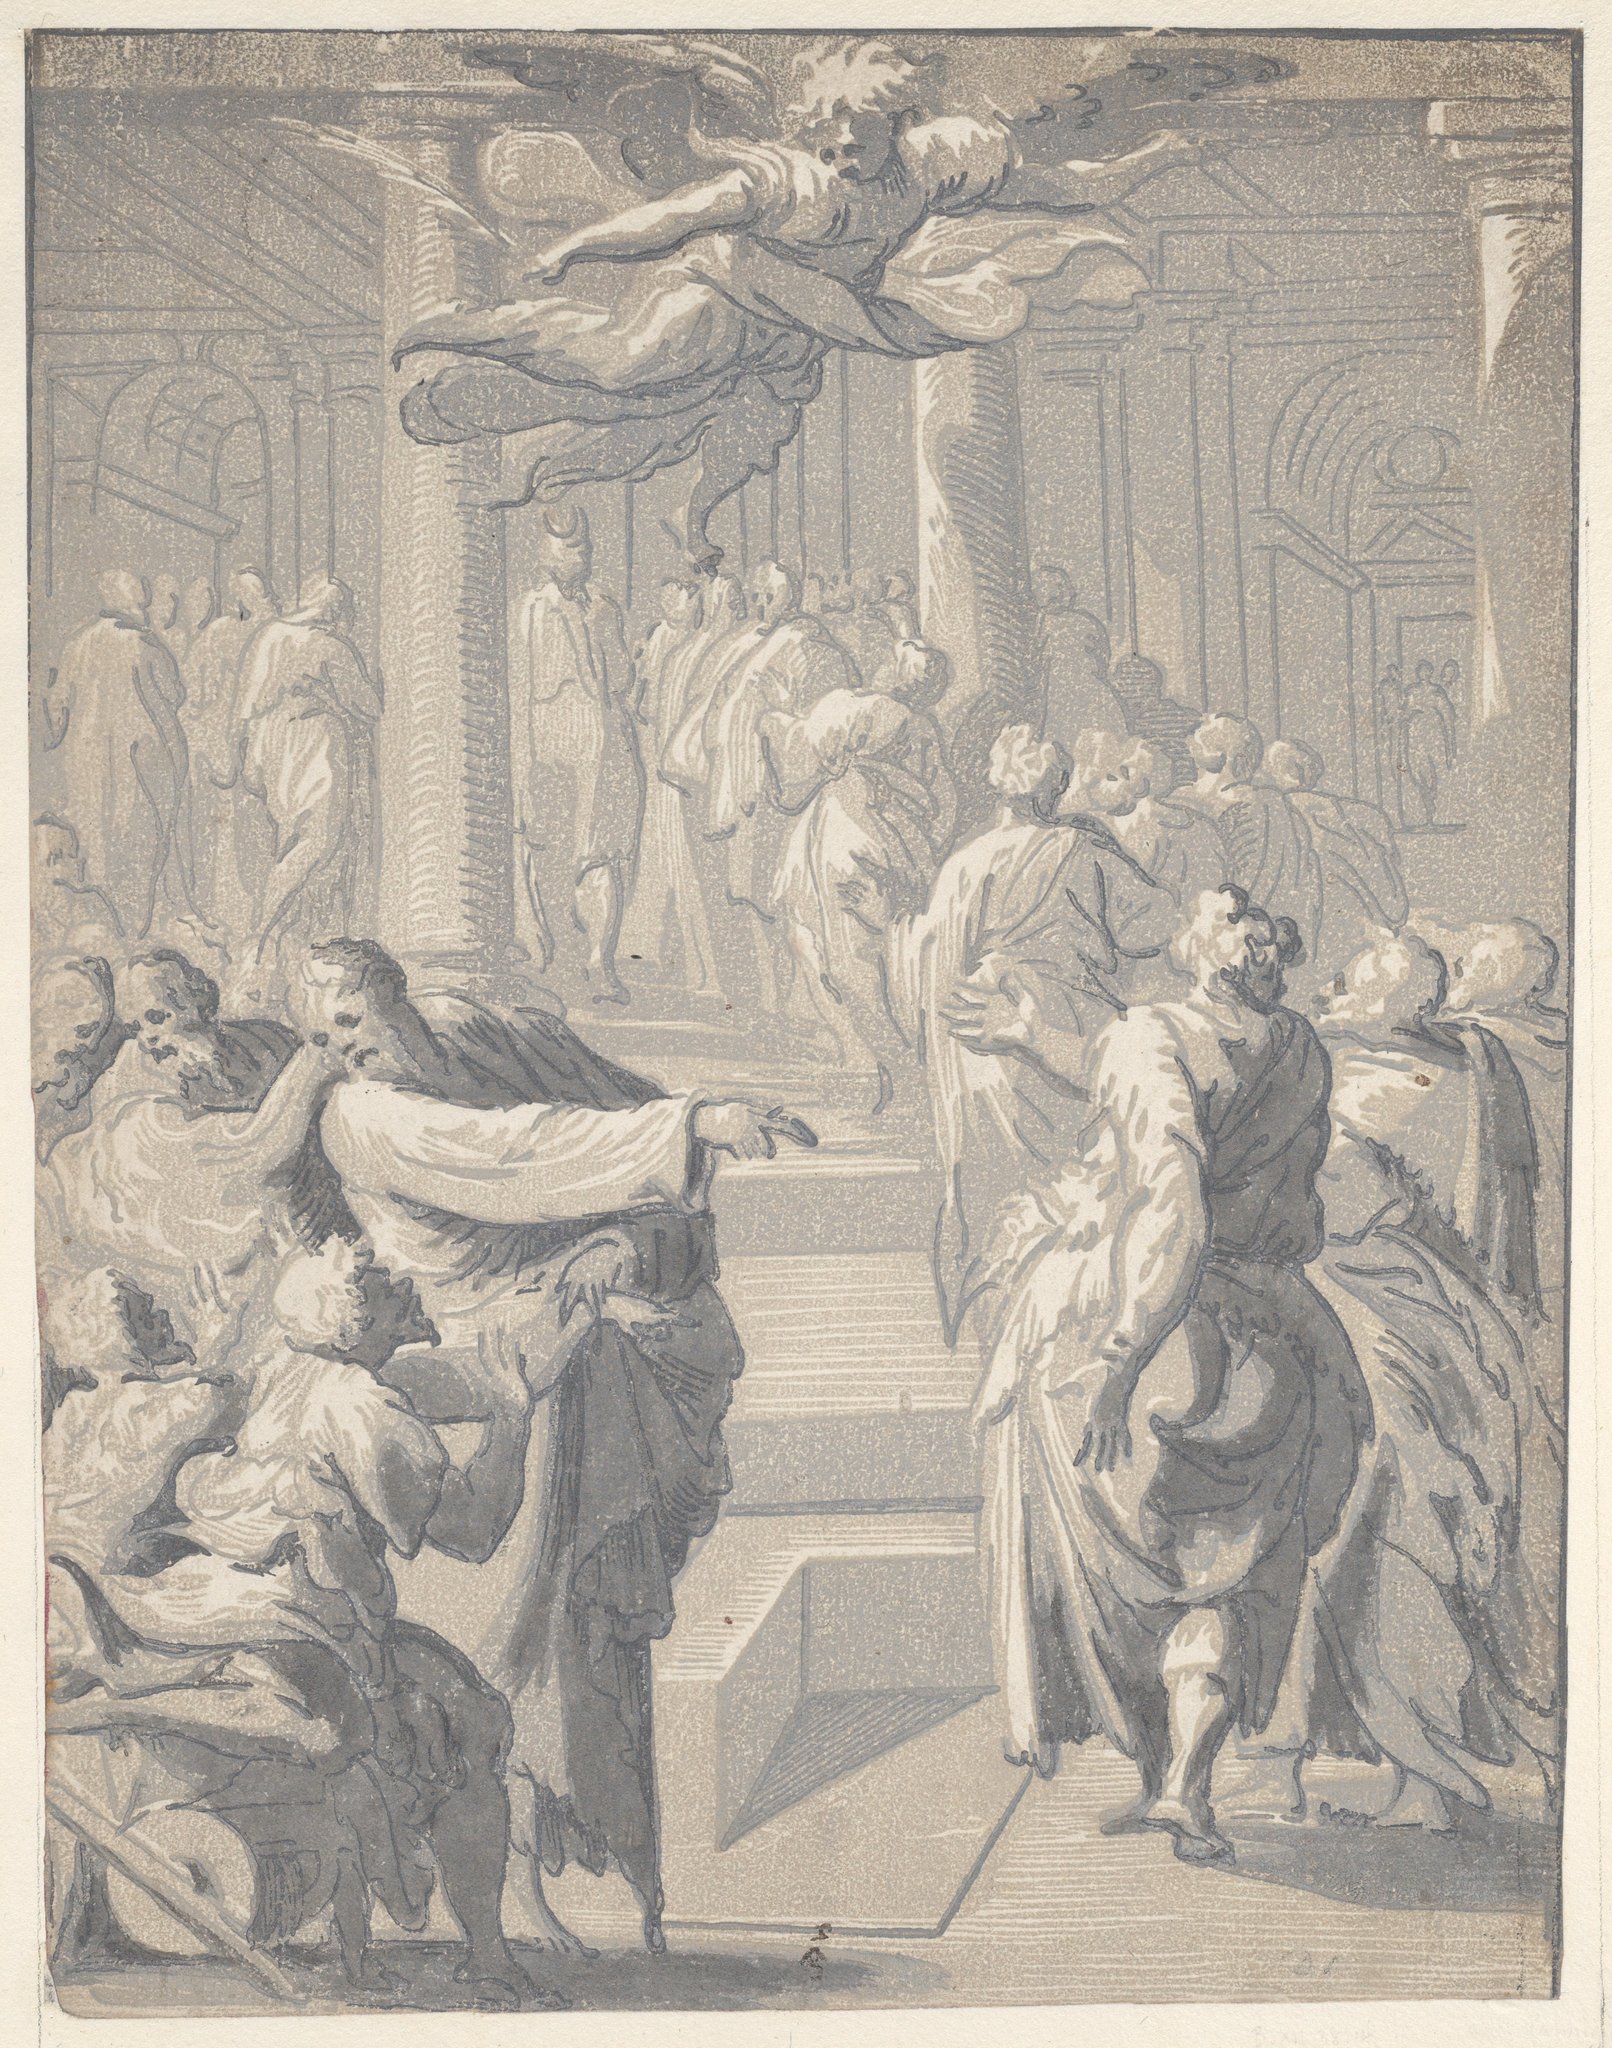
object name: print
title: Christ healing the paralytic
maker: niccolò vicentino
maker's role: artist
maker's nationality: italian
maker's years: 1510-1550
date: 1540-1550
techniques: woodcut